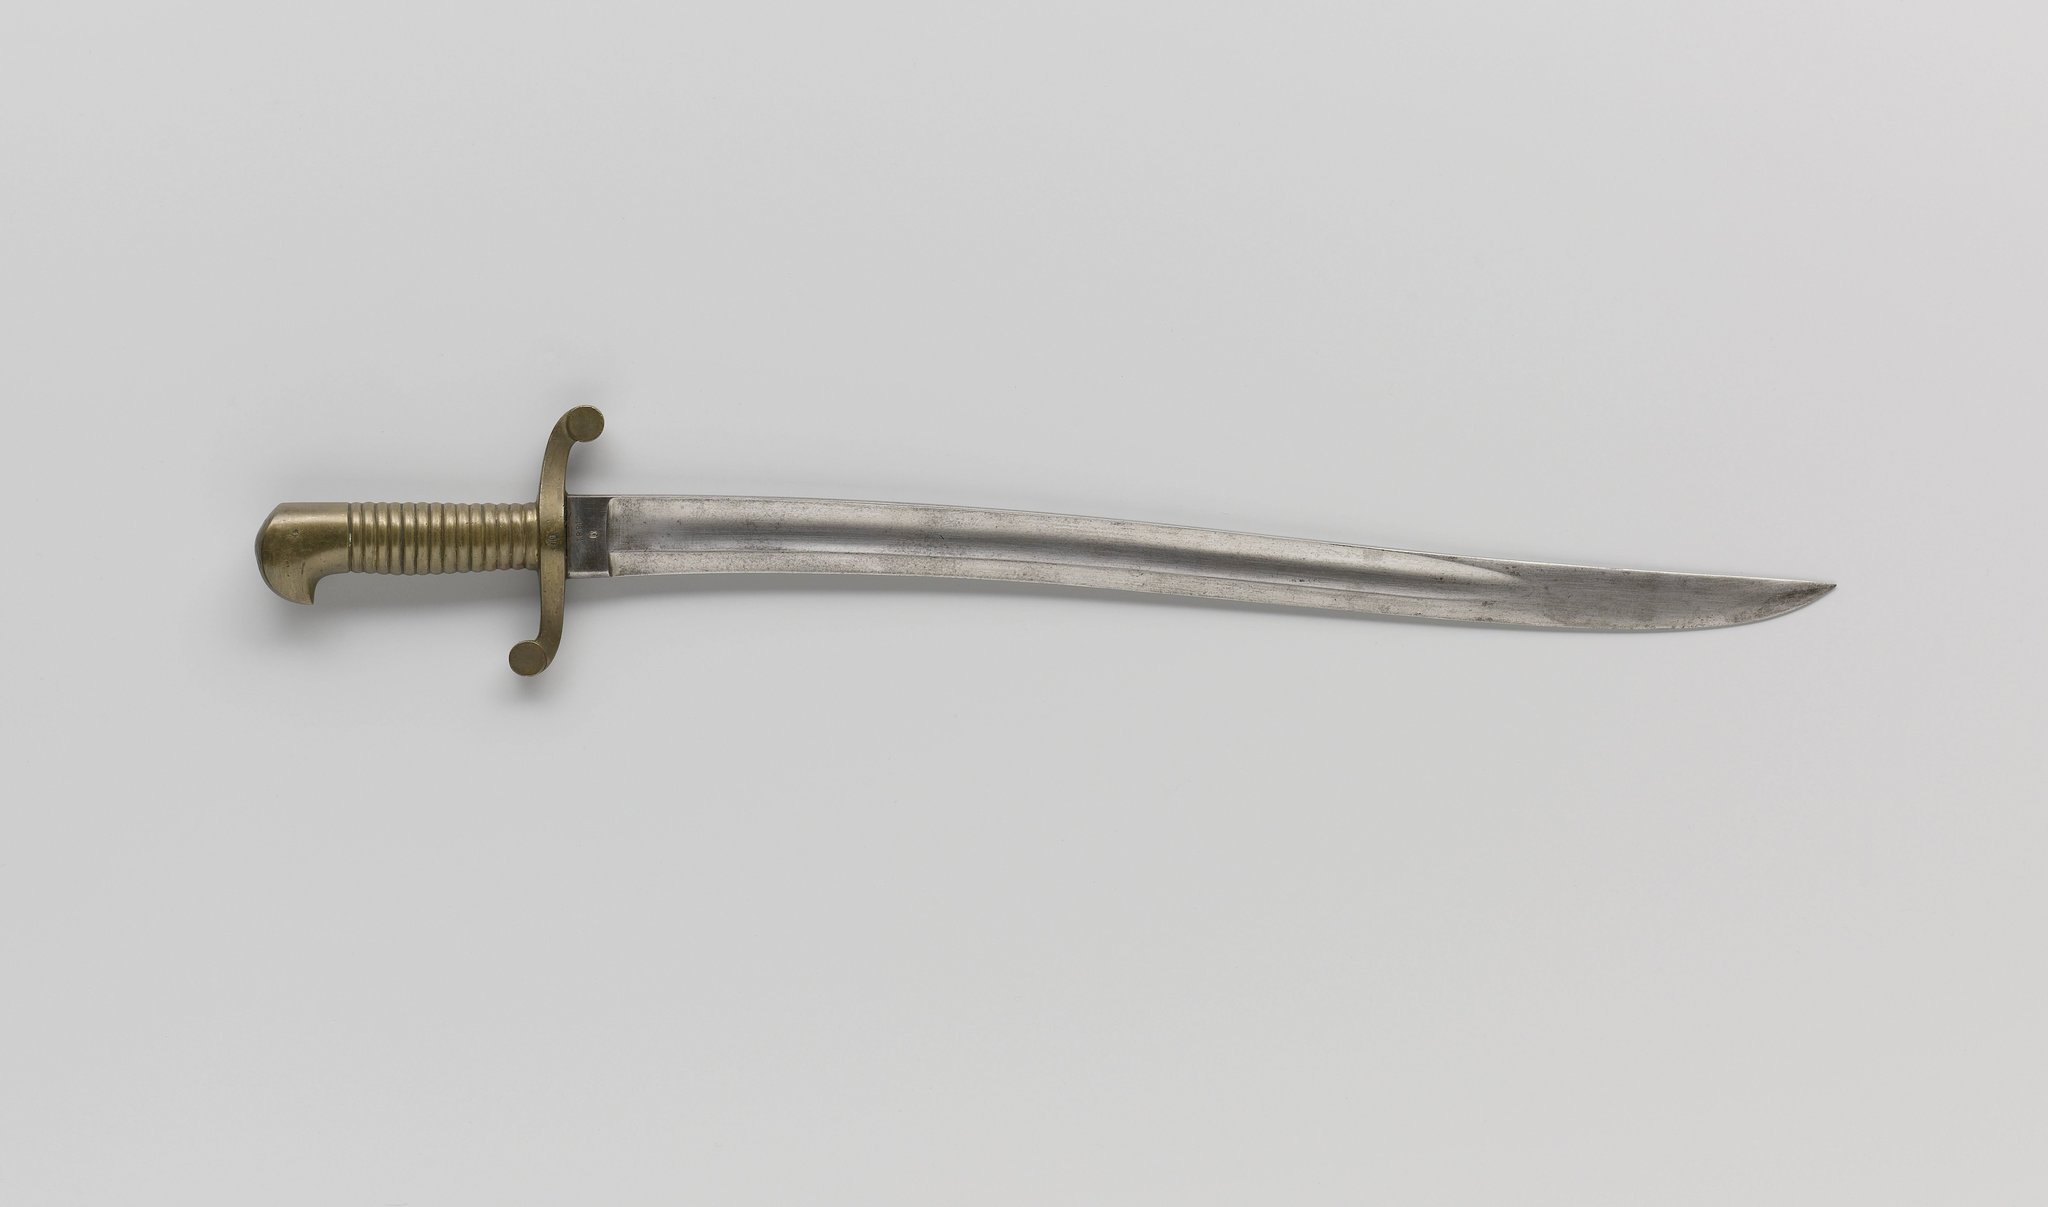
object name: sword bayonet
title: Bayonet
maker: p. stevens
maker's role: geweermaker, pistoolmaker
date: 1862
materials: bronze, iron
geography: maastricht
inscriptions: inscription: ‘S & K / 1861 // 208’